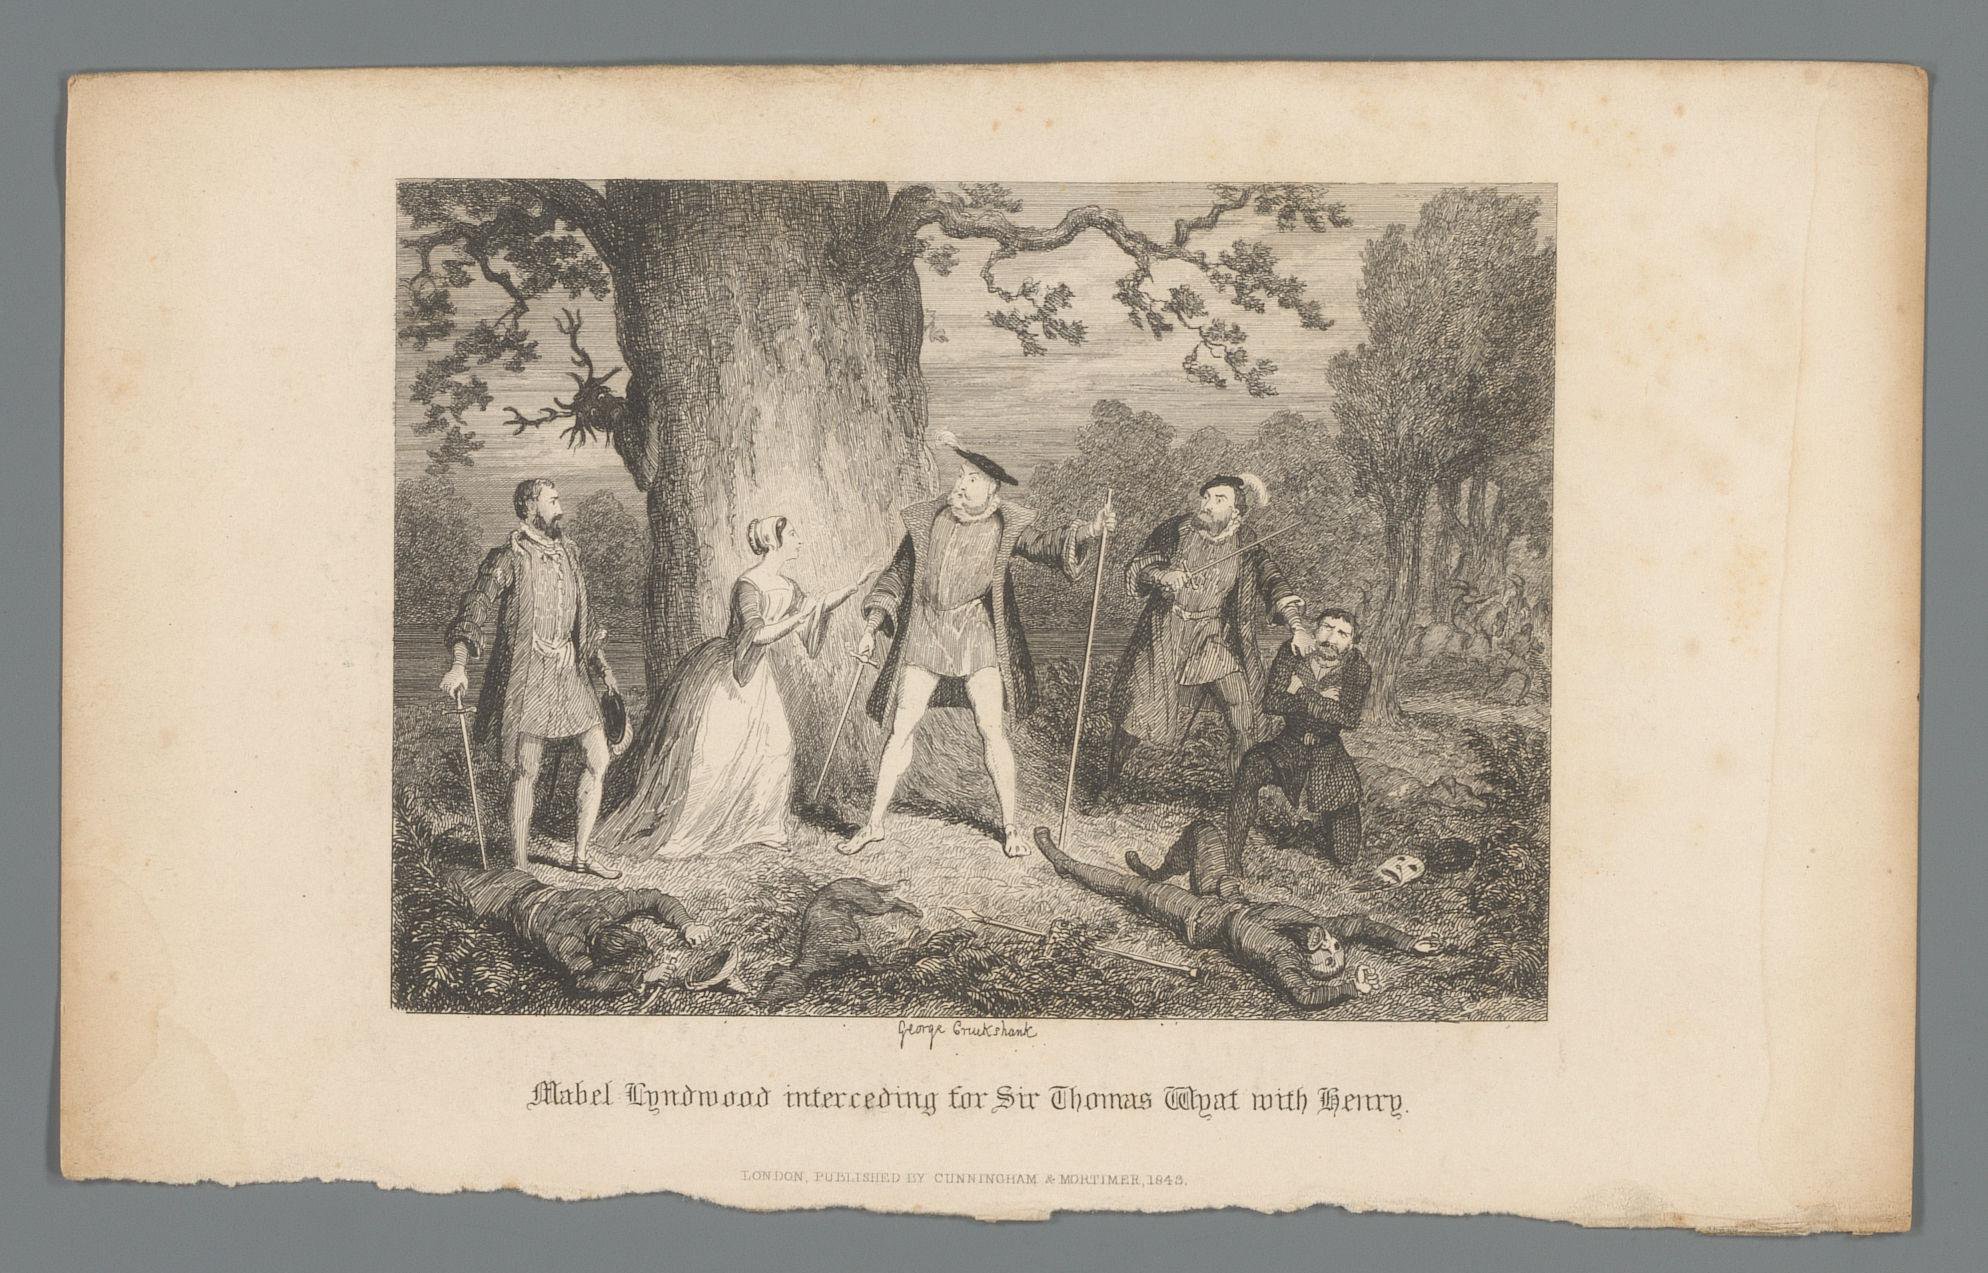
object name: cartoon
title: Mabel Lyndwood interceding for Sir Thomas Wyat with Henry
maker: george cruikshank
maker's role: painter, print maker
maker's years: 1792-1878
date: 1843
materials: paper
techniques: etching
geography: england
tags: political caricatures and satires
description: Mabel Lyndwood pleit bij koning Hendrik VIII voor het leven van Thomas Wyatt, die gewond op de grond ligt. Illustratie uit een uitgave van "Windsor Castle", van William Ainsworth (1843).